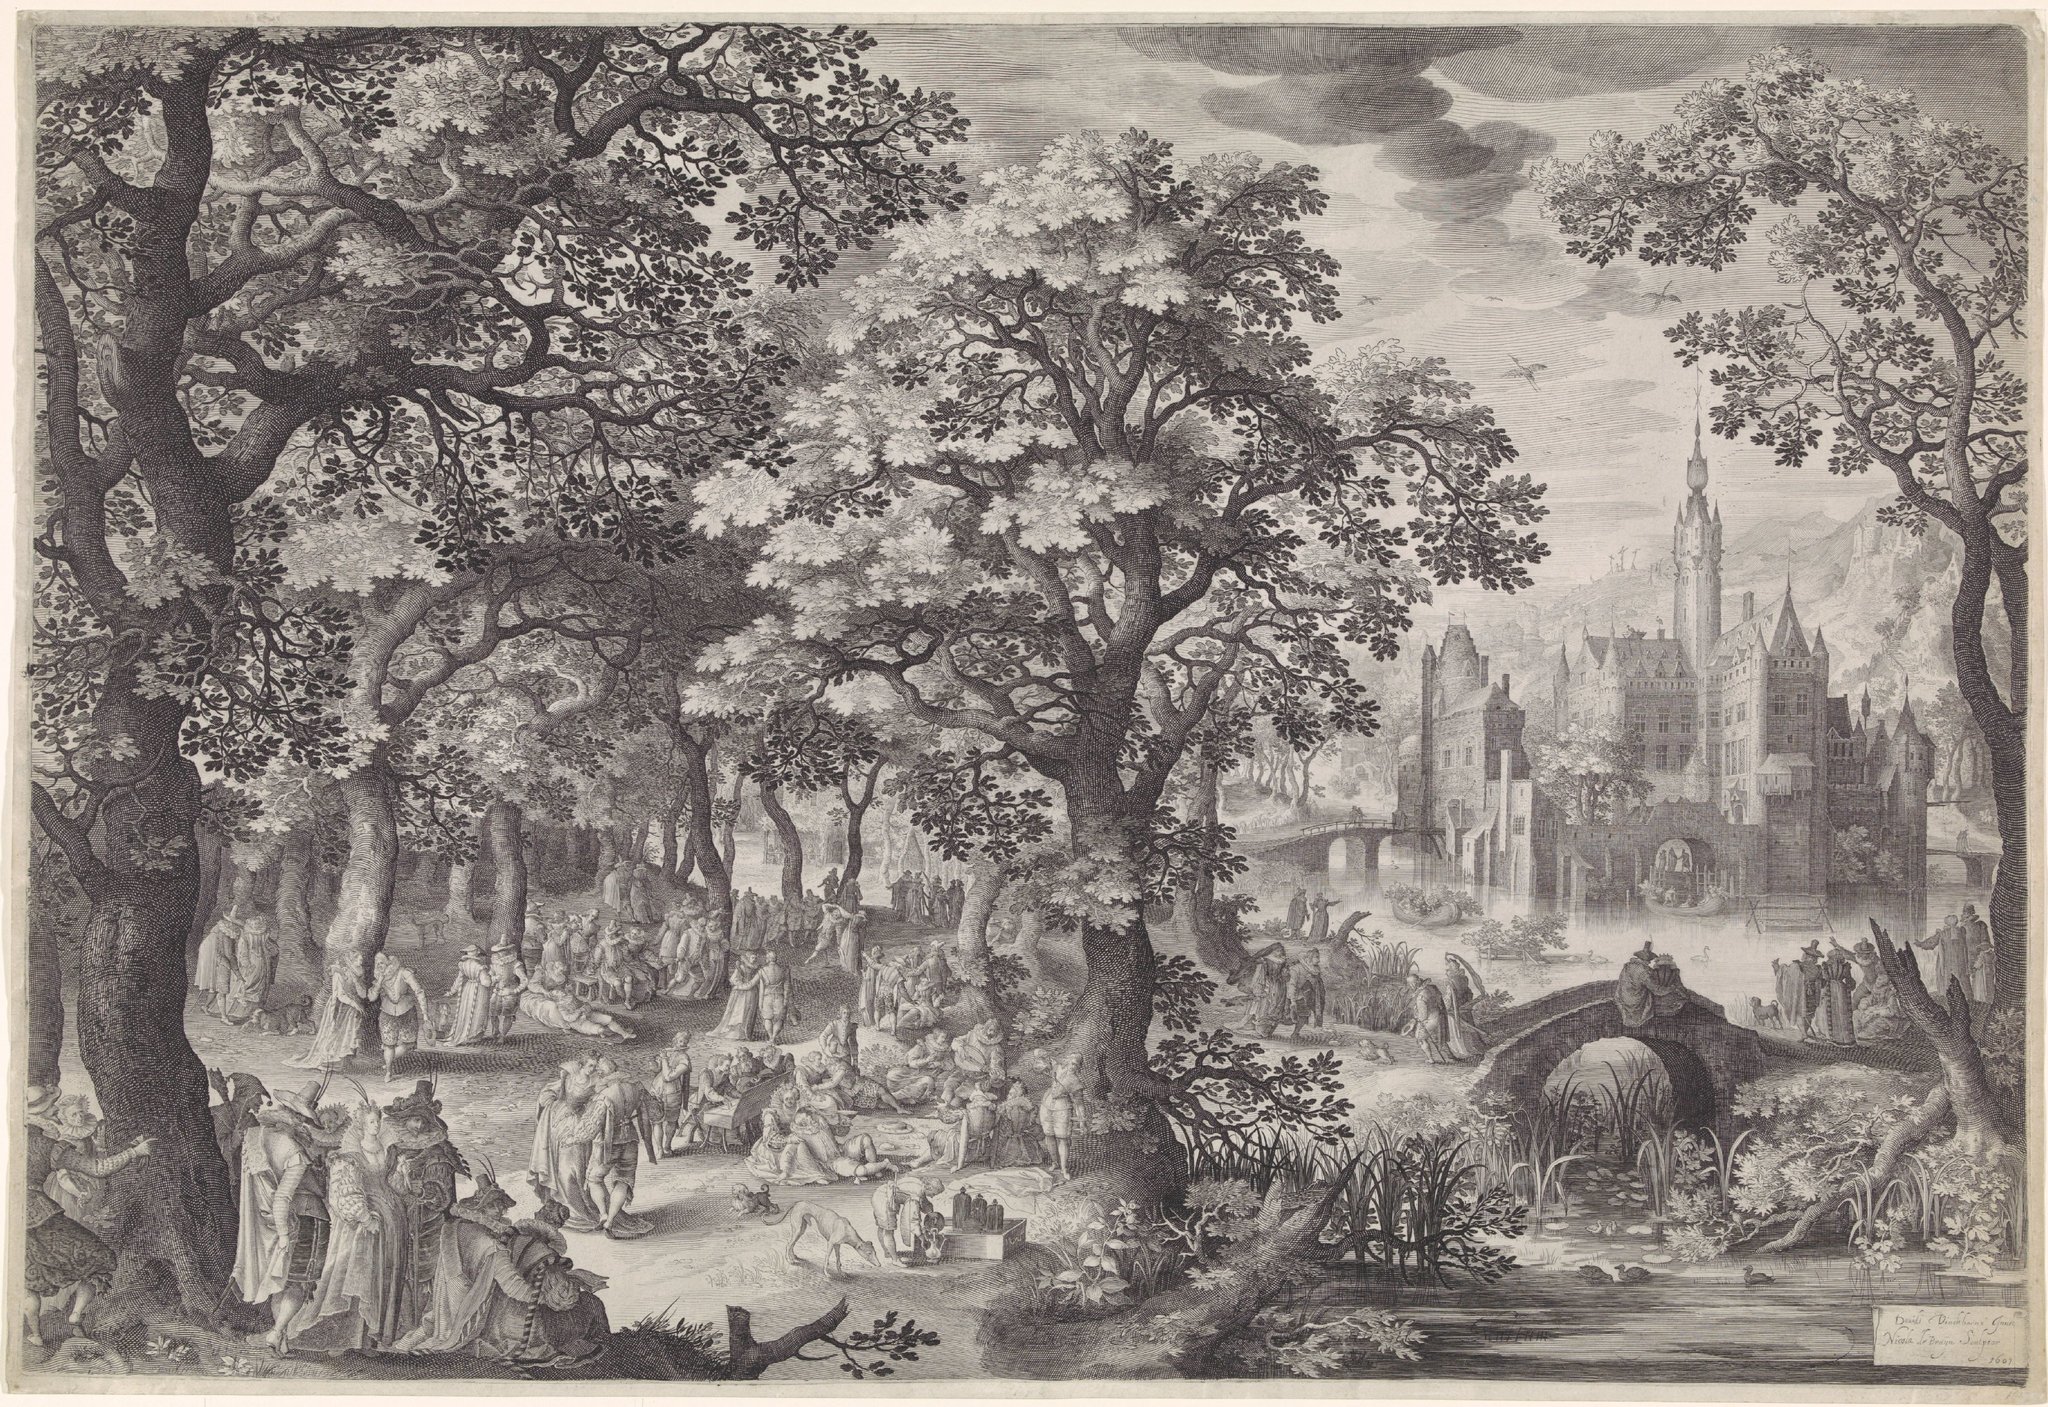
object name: print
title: Feast in the woods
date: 1601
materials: paper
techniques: engraving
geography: antwerp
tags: castle, private festivities, merry company - aa - in the open air, 'fête champêtre'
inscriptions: collector's mark: Lugt 2228, caption: ‘JH 25’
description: This famous rendering of an imaginary castle in a landscape by De Bruyn was possibly a source of inspiration for Roghman. As well as being a haven of safety, a castle was also considered a ‘castle of love.’ In this print, Mary Magdalene (left foreground) and her entourage make merry in the woods. The obviously amorous atmosphere contrasts with the three crosses in the distance, a reference to Christ’s suffering.